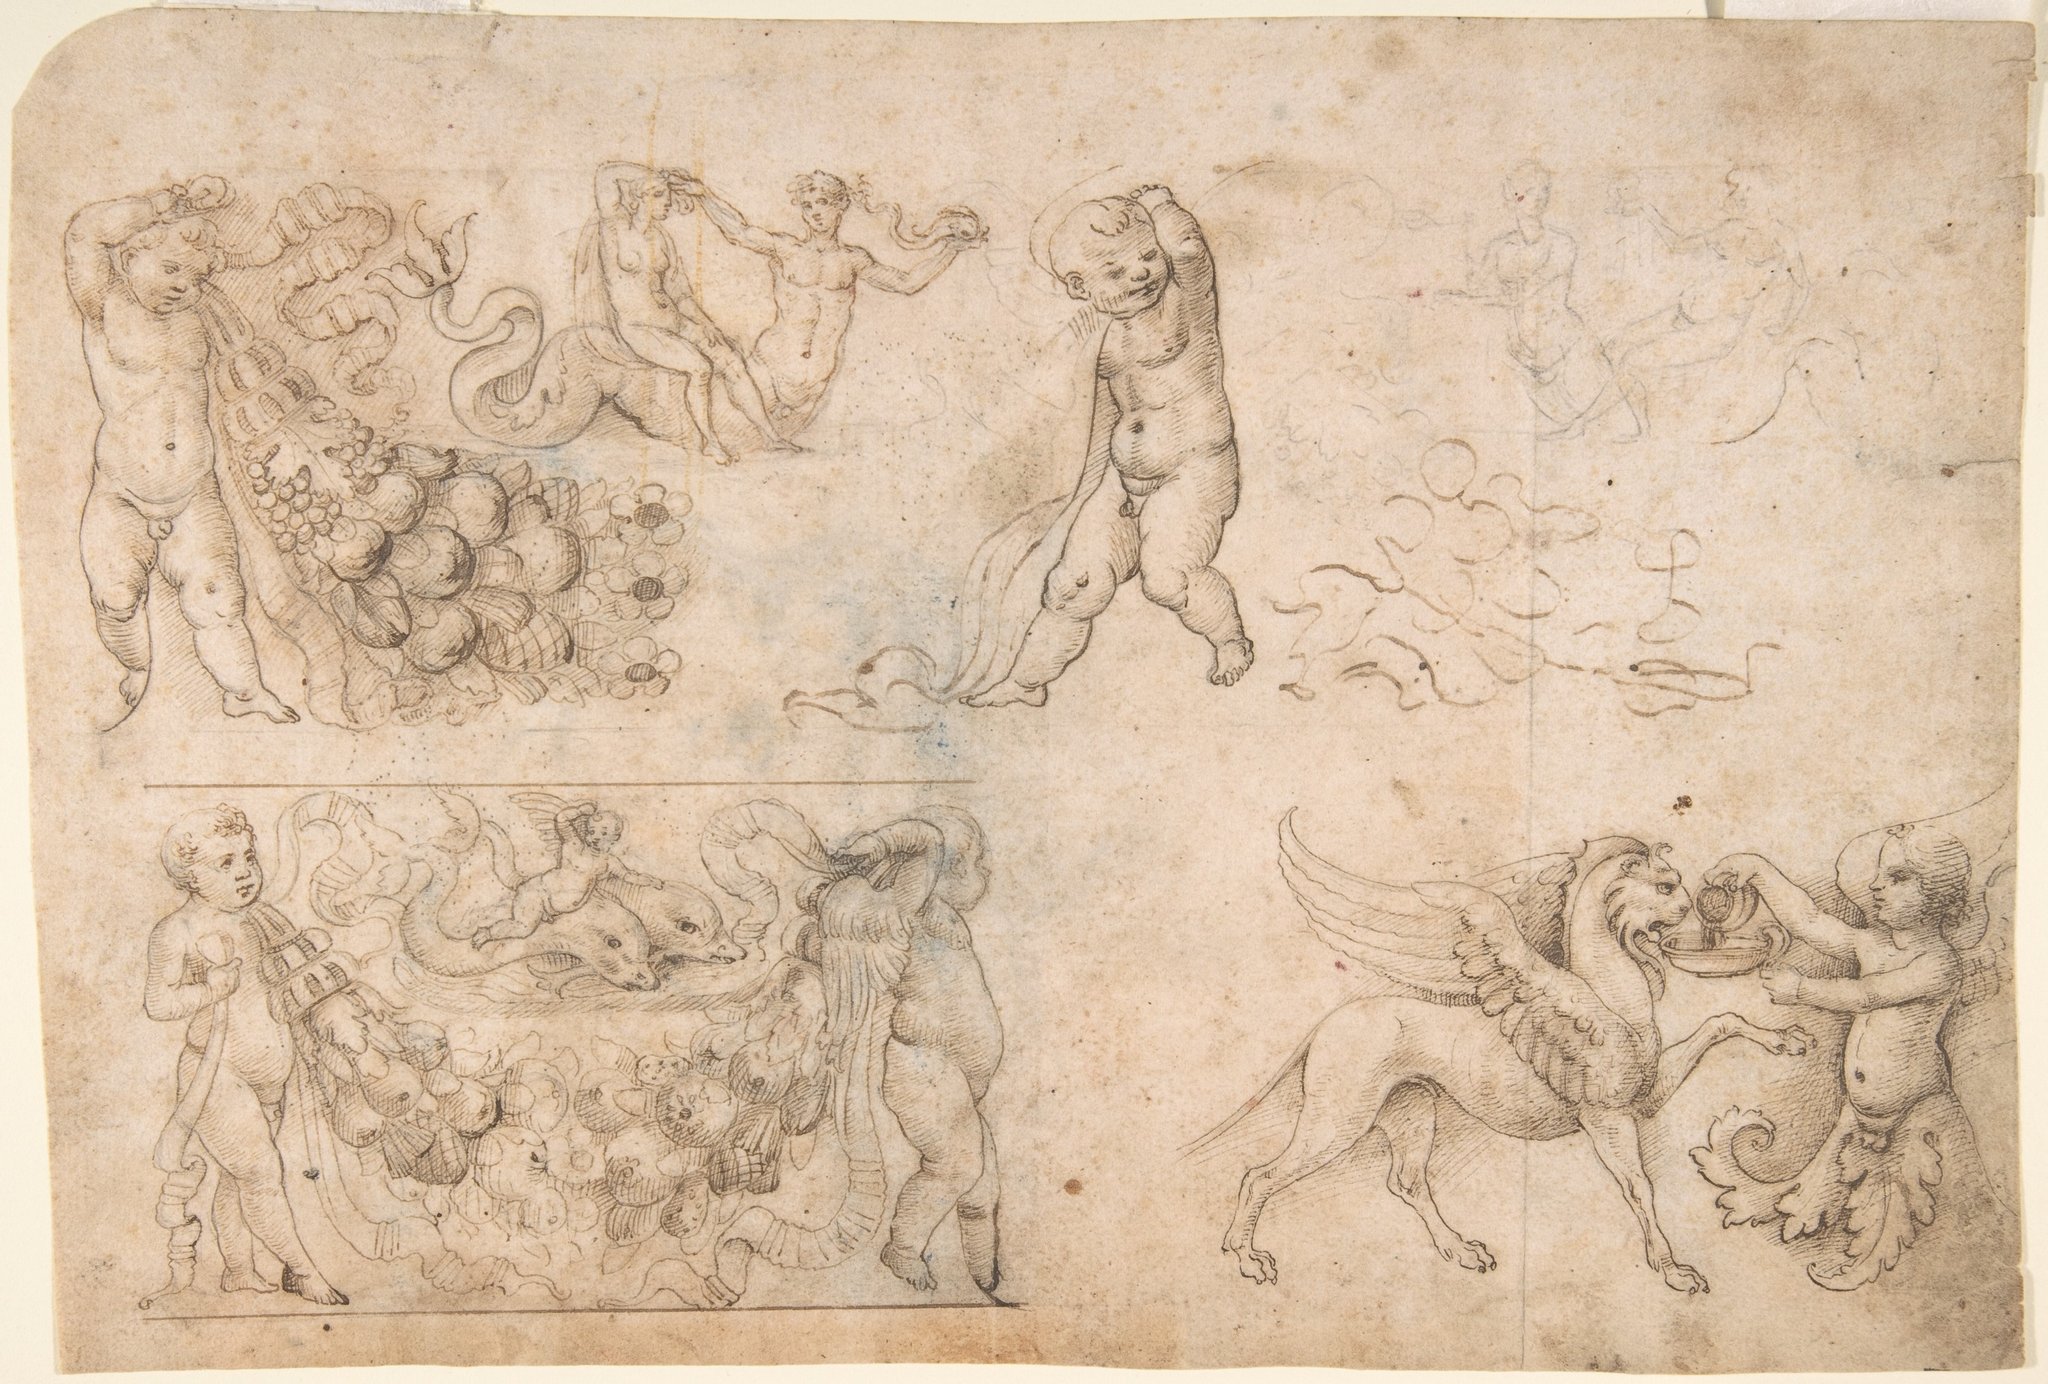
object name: drawing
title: Studies after Antique Frieze Figures, Including Putti with Garlands, with a Chimera and Dolphins (recto); Sketch of a Head (verso)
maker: anonymous, italian, tuscan, late 15th century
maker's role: artist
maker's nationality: italian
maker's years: 1450-1500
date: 1490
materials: graphite, ink, drawing material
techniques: pen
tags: fruit,infants